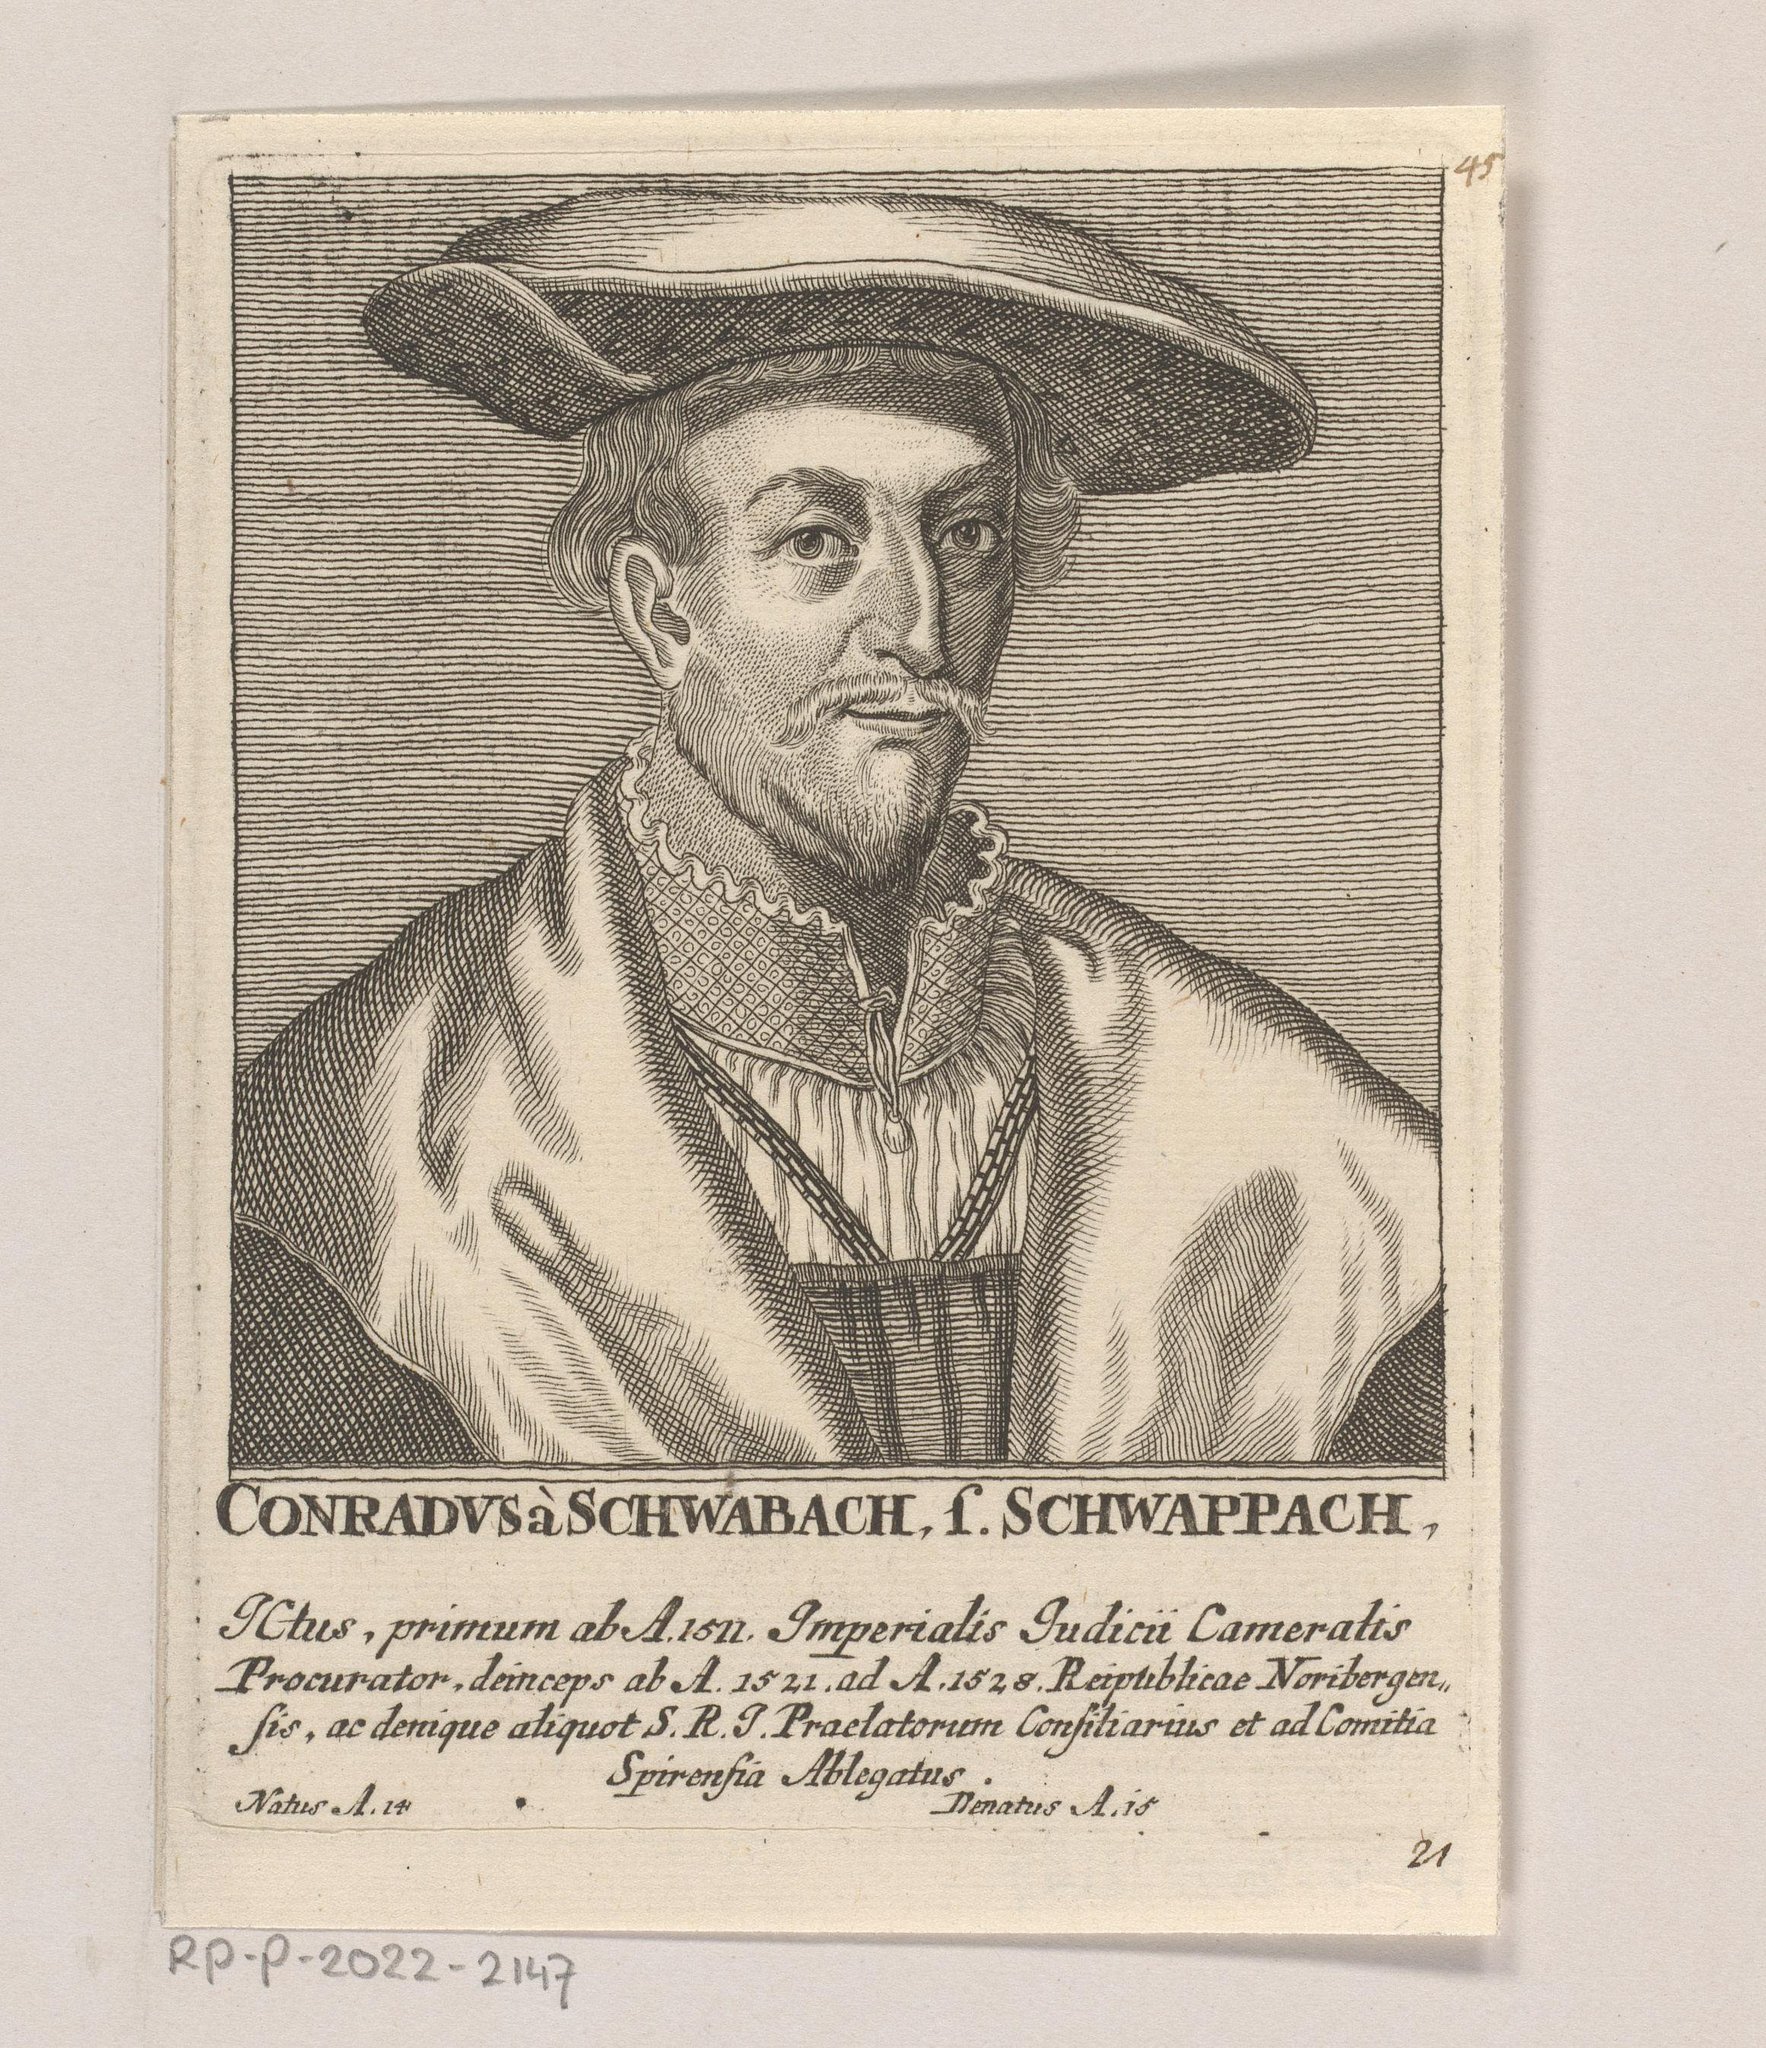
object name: print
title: Portret van Conrad von Swappach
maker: Anonymous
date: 1725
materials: paper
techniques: engraving, etching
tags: historical persons, lawyer, attorney at law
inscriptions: number: ‘45’, number: ‘21’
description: Prent mogelijk uit: Rothscholtz, Friedrich. Icones virorum omnium ordinum eruditione: omnique item genere et varietate artium de republica litteraria et speciatim de Academiis et Gymnasiis (...). Neurenberg: erven Johann Daniel Tauber, 1725, dl. 1 of 2.